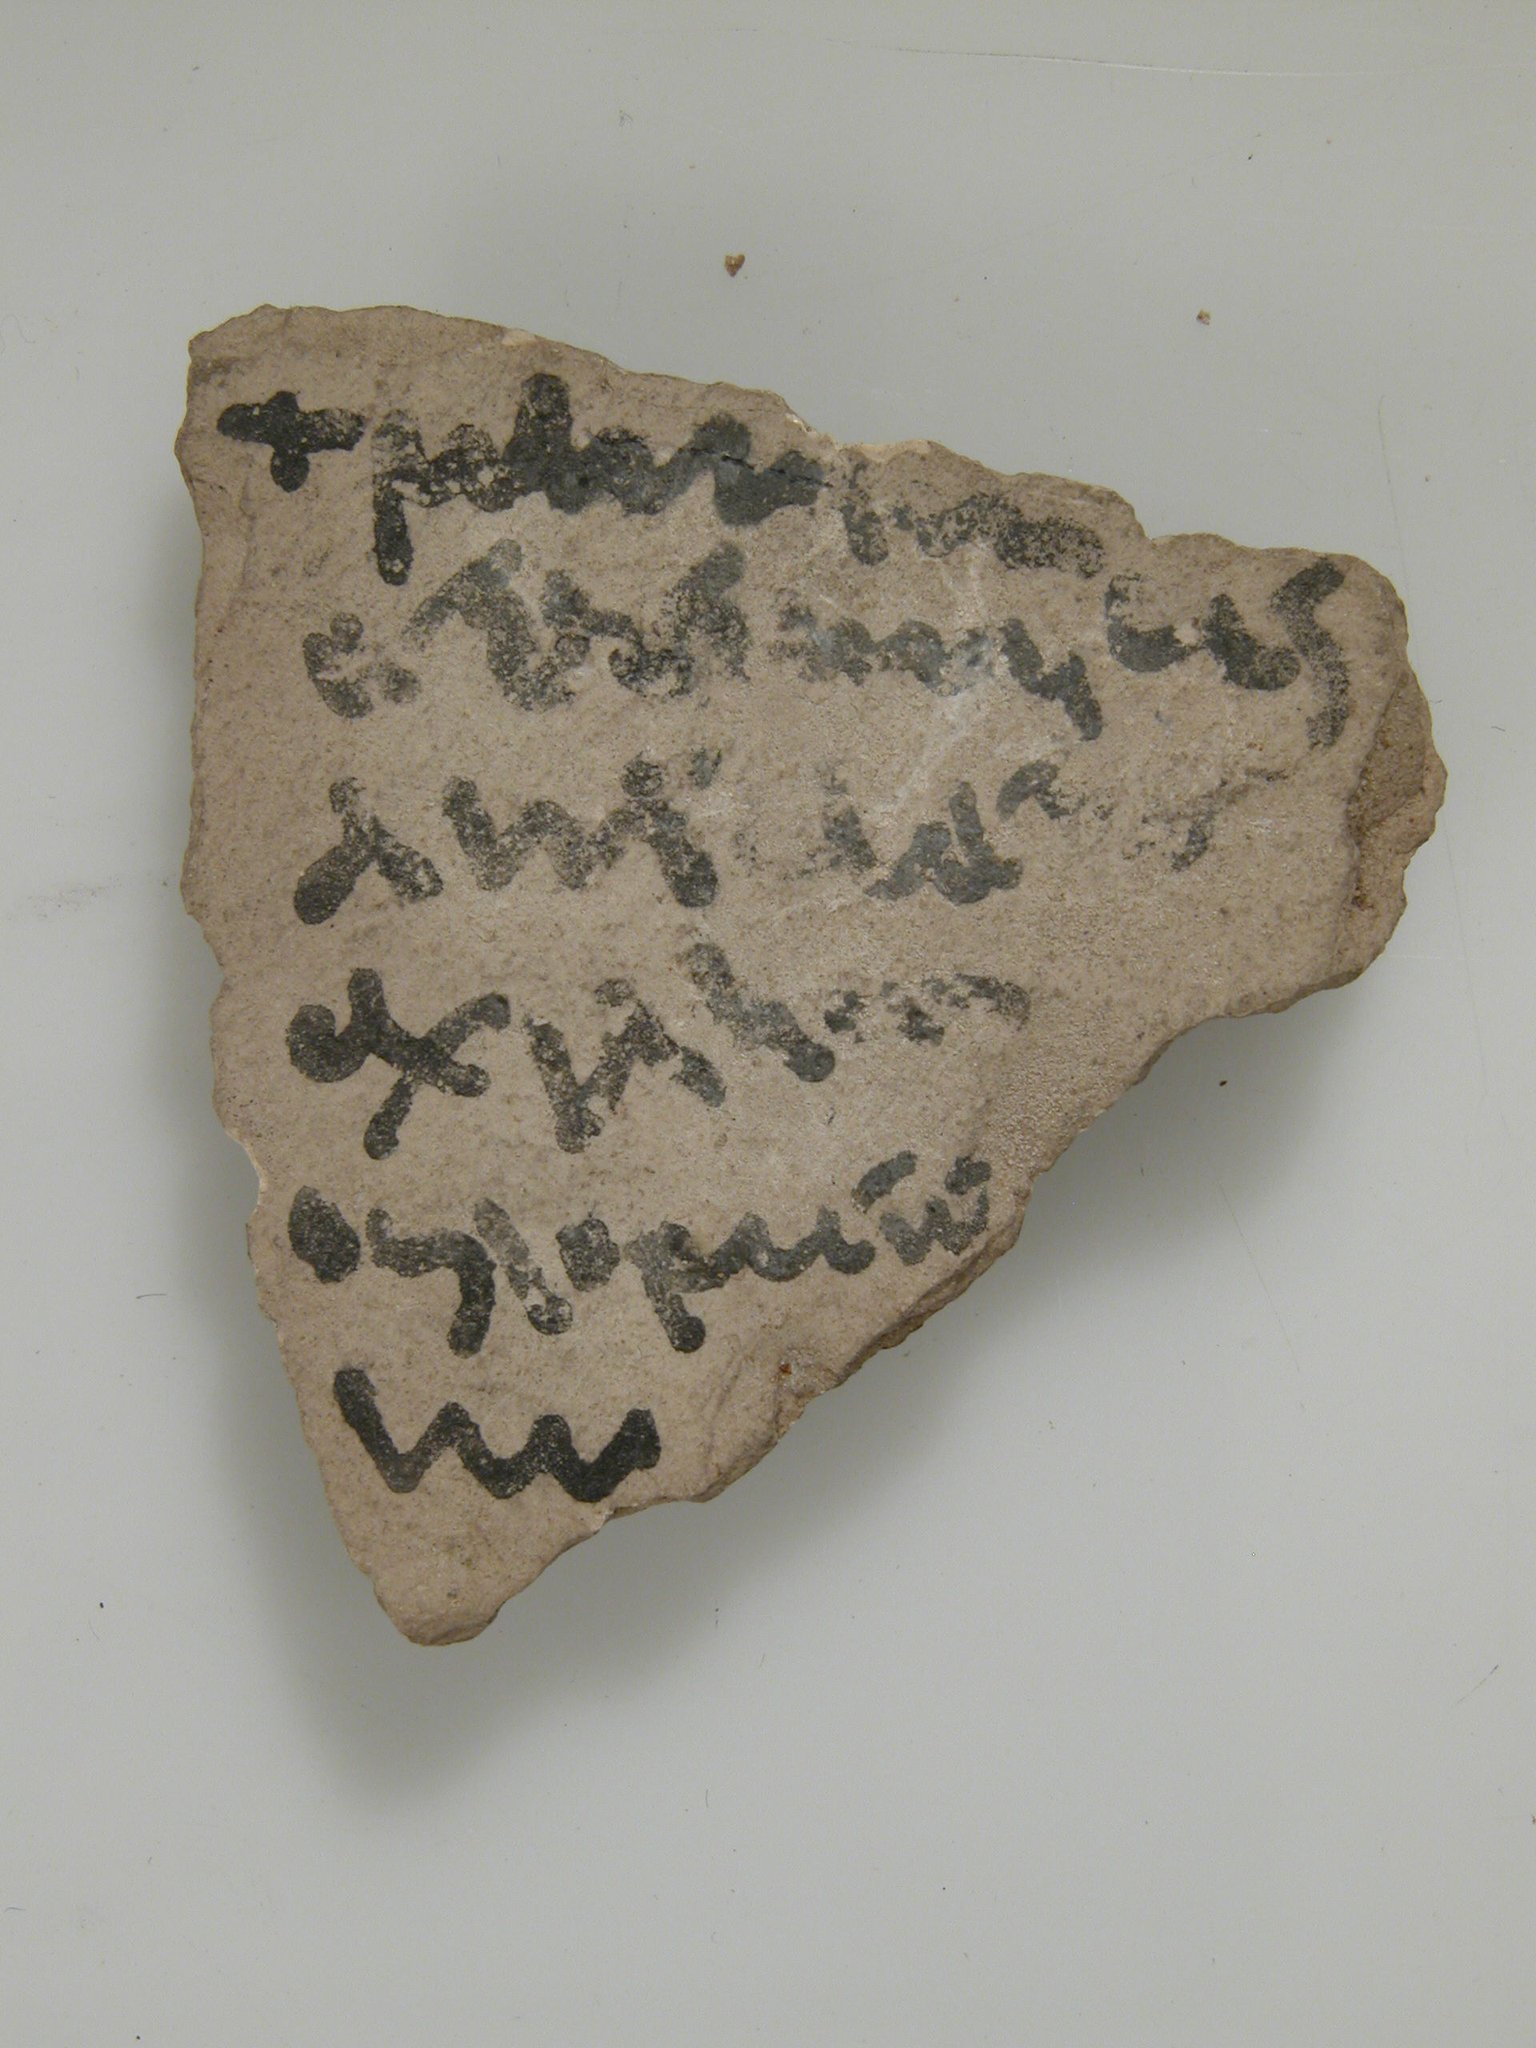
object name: ostrakon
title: Ostrakon with Lines from Homer's Iliad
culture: coptic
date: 600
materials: ink, limestone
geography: egypt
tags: greek